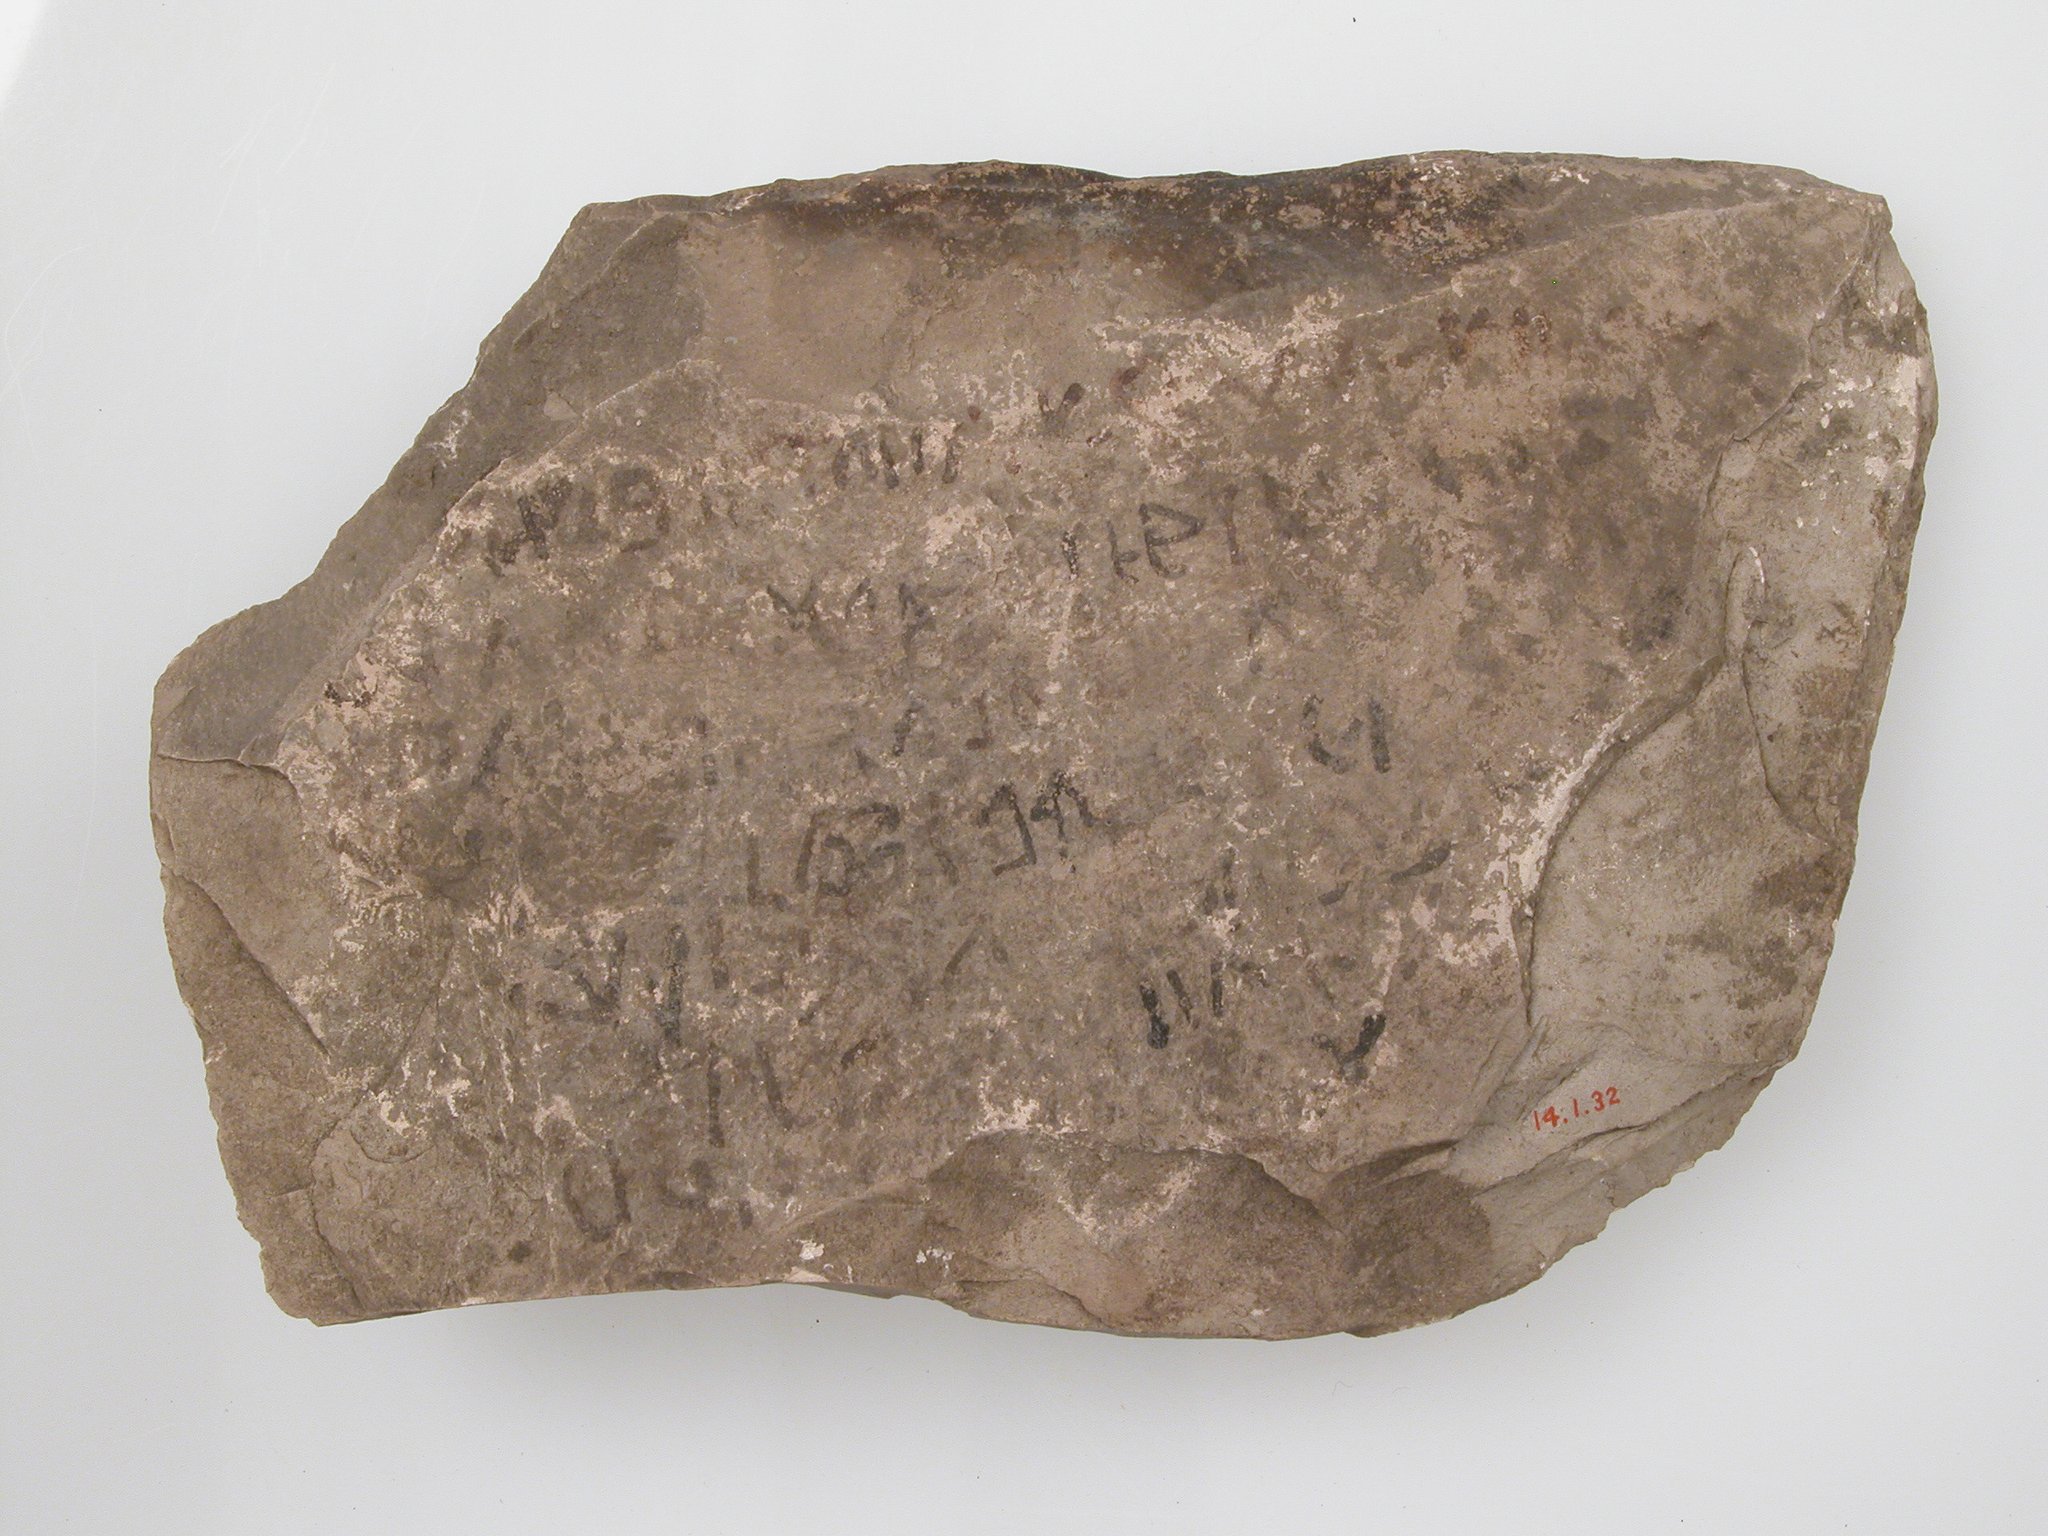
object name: ostrakon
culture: coptic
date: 600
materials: ink, limestone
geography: egypt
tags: coptic,documents